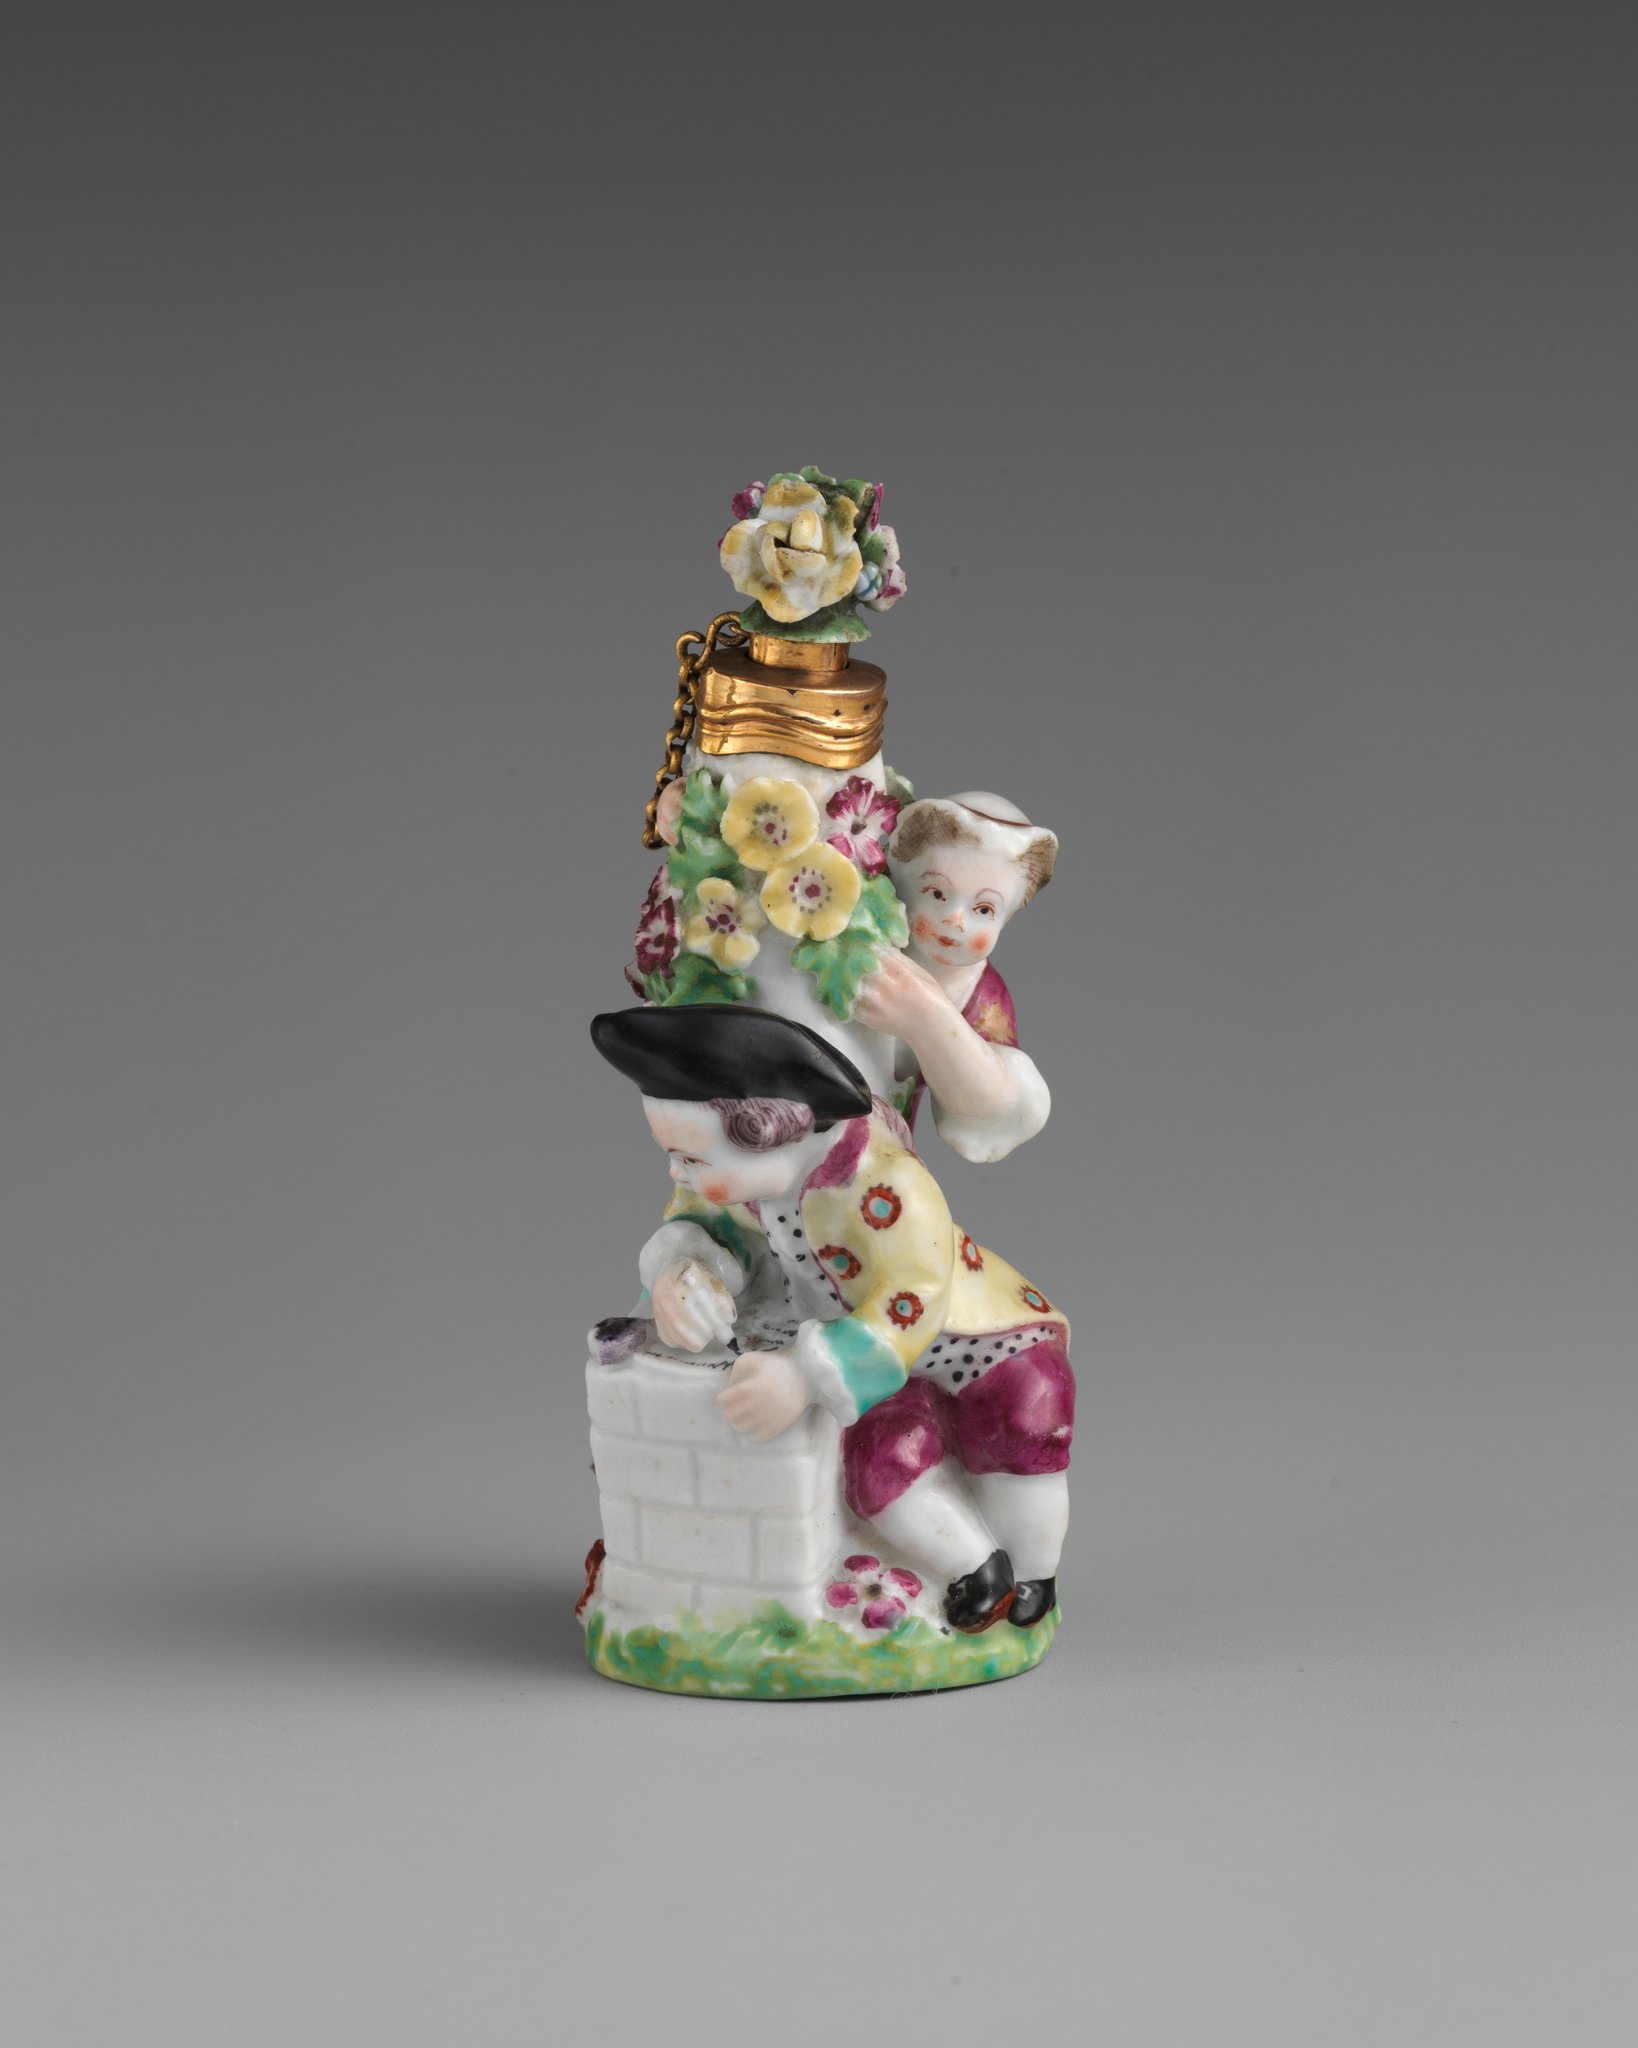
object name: toy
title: Boy letter-writer and girl in group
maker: chelsea porcelain manufactory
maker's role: factory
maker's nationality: british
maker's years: 1744-1784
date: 1759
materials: soft paste porcelain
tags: boys,girls,flowers,writing